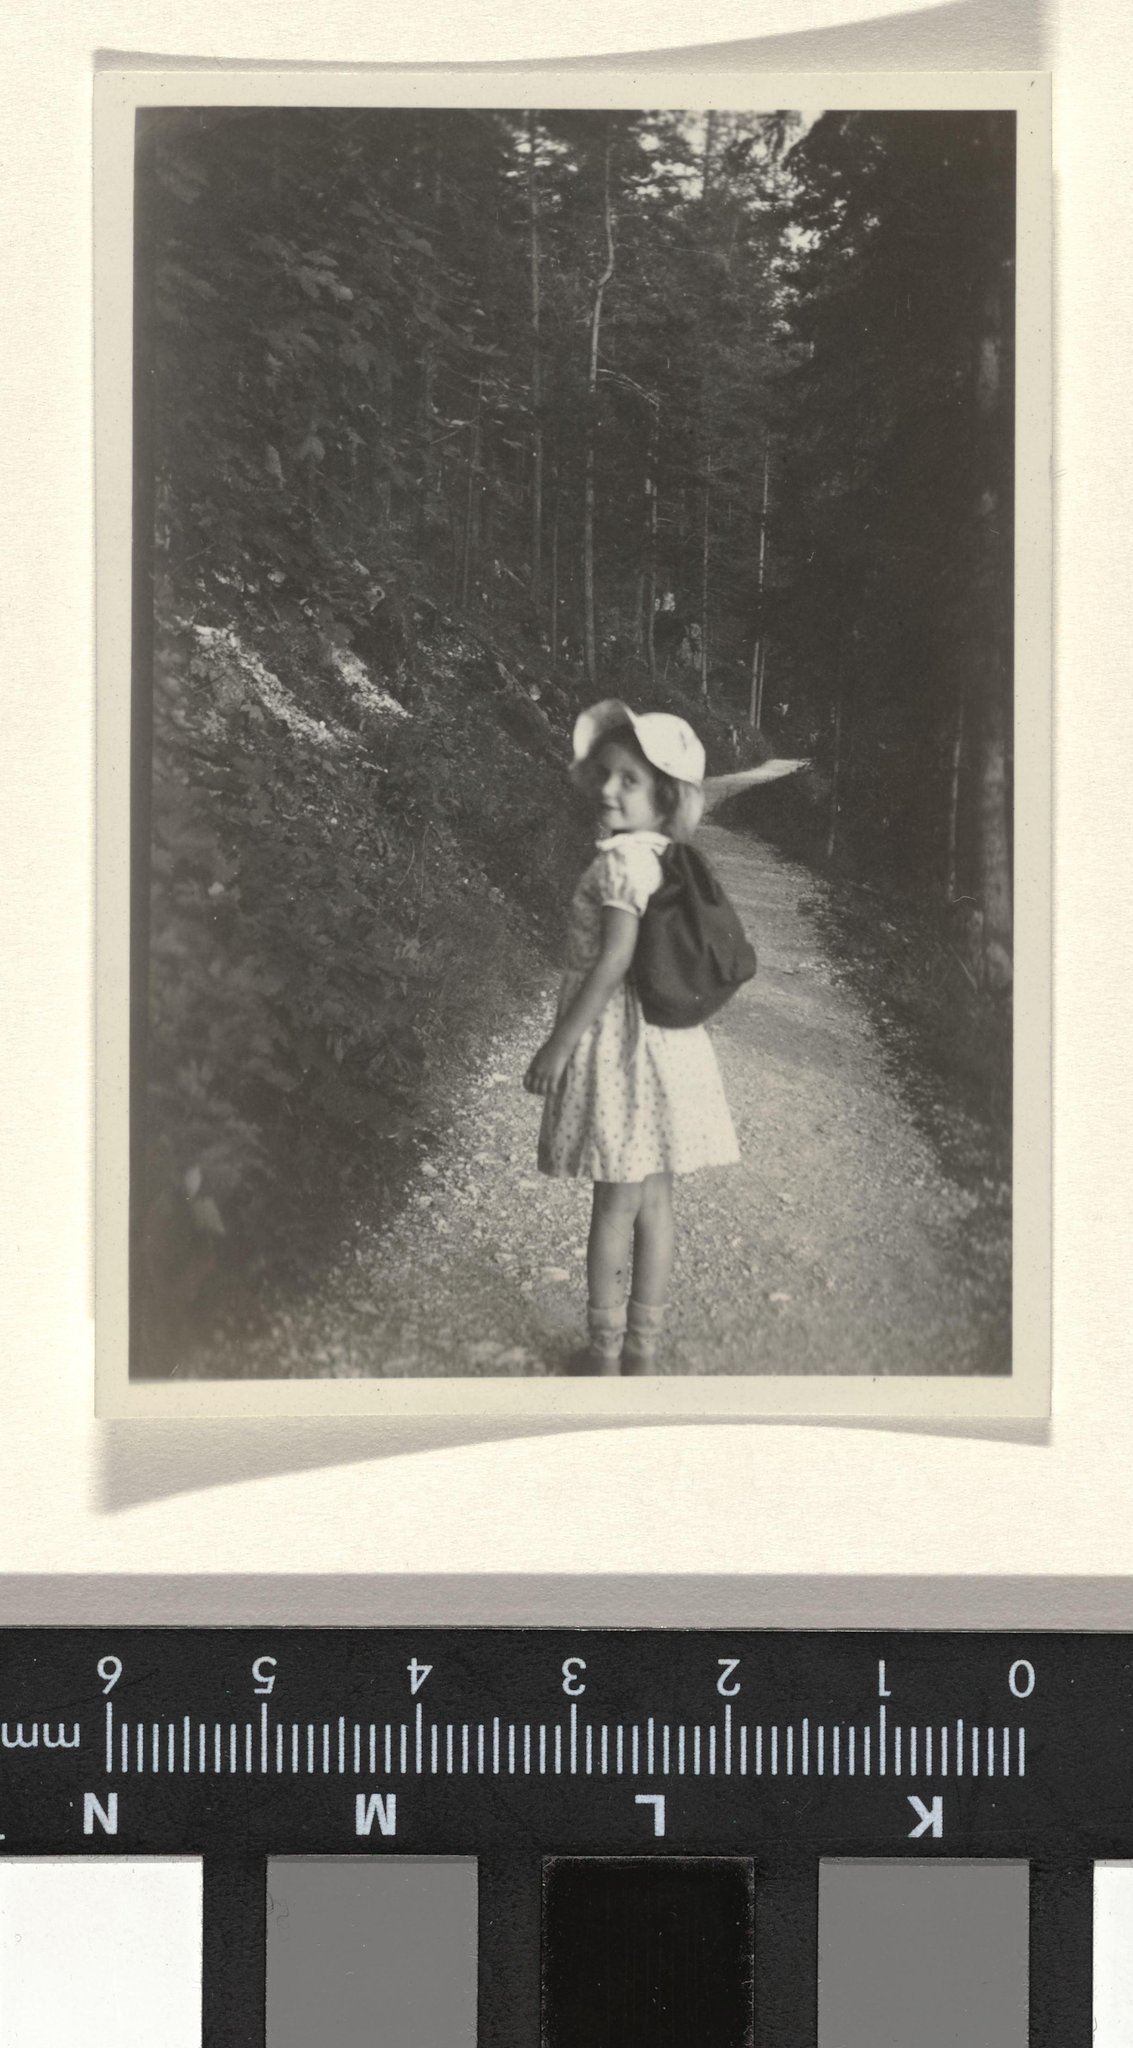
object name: photograph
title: Isabel Wachenheimer stilstaand op een bergpad bij de Eibsee, augustus 1932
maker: Anonymous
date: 1908-1932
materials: photographic support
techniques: gelatin silver print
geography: bavaria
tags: leiden, isabel wachenheimer-elon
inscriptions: number: ‘851’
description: Dit object is onderdeel van de nalatenschap van Isabel Elon-Wachenheimer (1928-2010). Tot haar overlijden behoorde het samen met de andere objecten uit de nalatenschap tot haar privédomein van Isabel Wachenheimer. In die particuliere context zijn deze objecten tezamen en individueel aandenkens - aan de jeugd, ouders en familie van Isabel Wachenheimer vóór en tijdens de Shoah en aan haar leven na de Tweede Wereldoorlog. Isabel Wachenheimer, die van juni 1943 tot mei 1945 gevangen zat in Kamp Westerbork, Theresienstadt, Auschwitz, Lenzing a/d Oberdonau (een buitenkamp van Mauthausen), overleefde de Shoah. Haar ouders – Eugène Wachenheimer en Else Wachenheimer-Moos - werden op 14 oktober 1944 in Auschwitz-Birkenau vermoord.